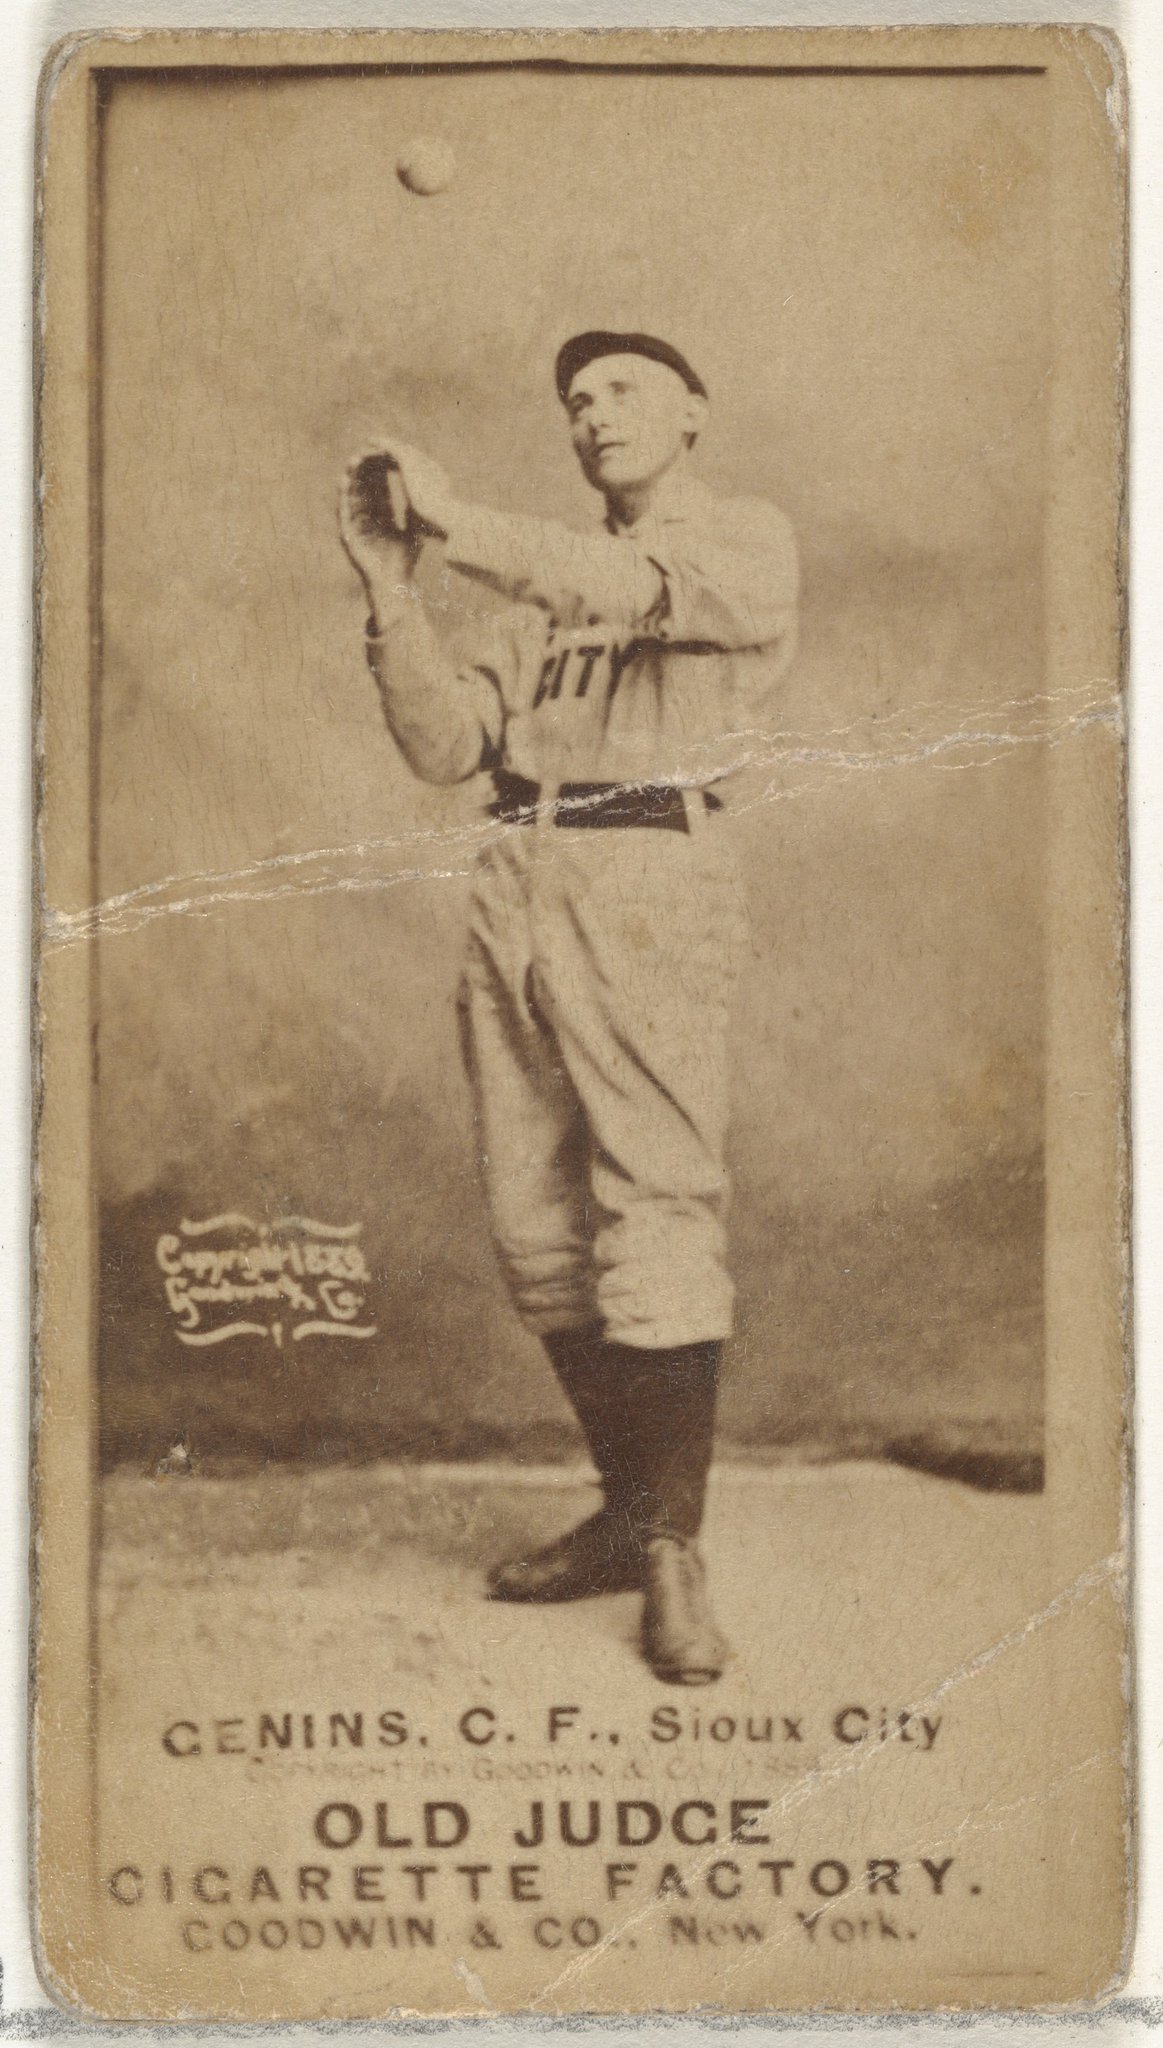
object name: baseball card, photograph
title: C. Frank Genins, Center Field, Sioux City Corn Huskers, from the Old Judge series (N172) for Old Judge Cigarettes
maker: goodwin & company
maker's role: publisher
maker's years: 1850-1950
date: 1889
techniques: albumen silver print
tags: men,portraits,baseball,athletes